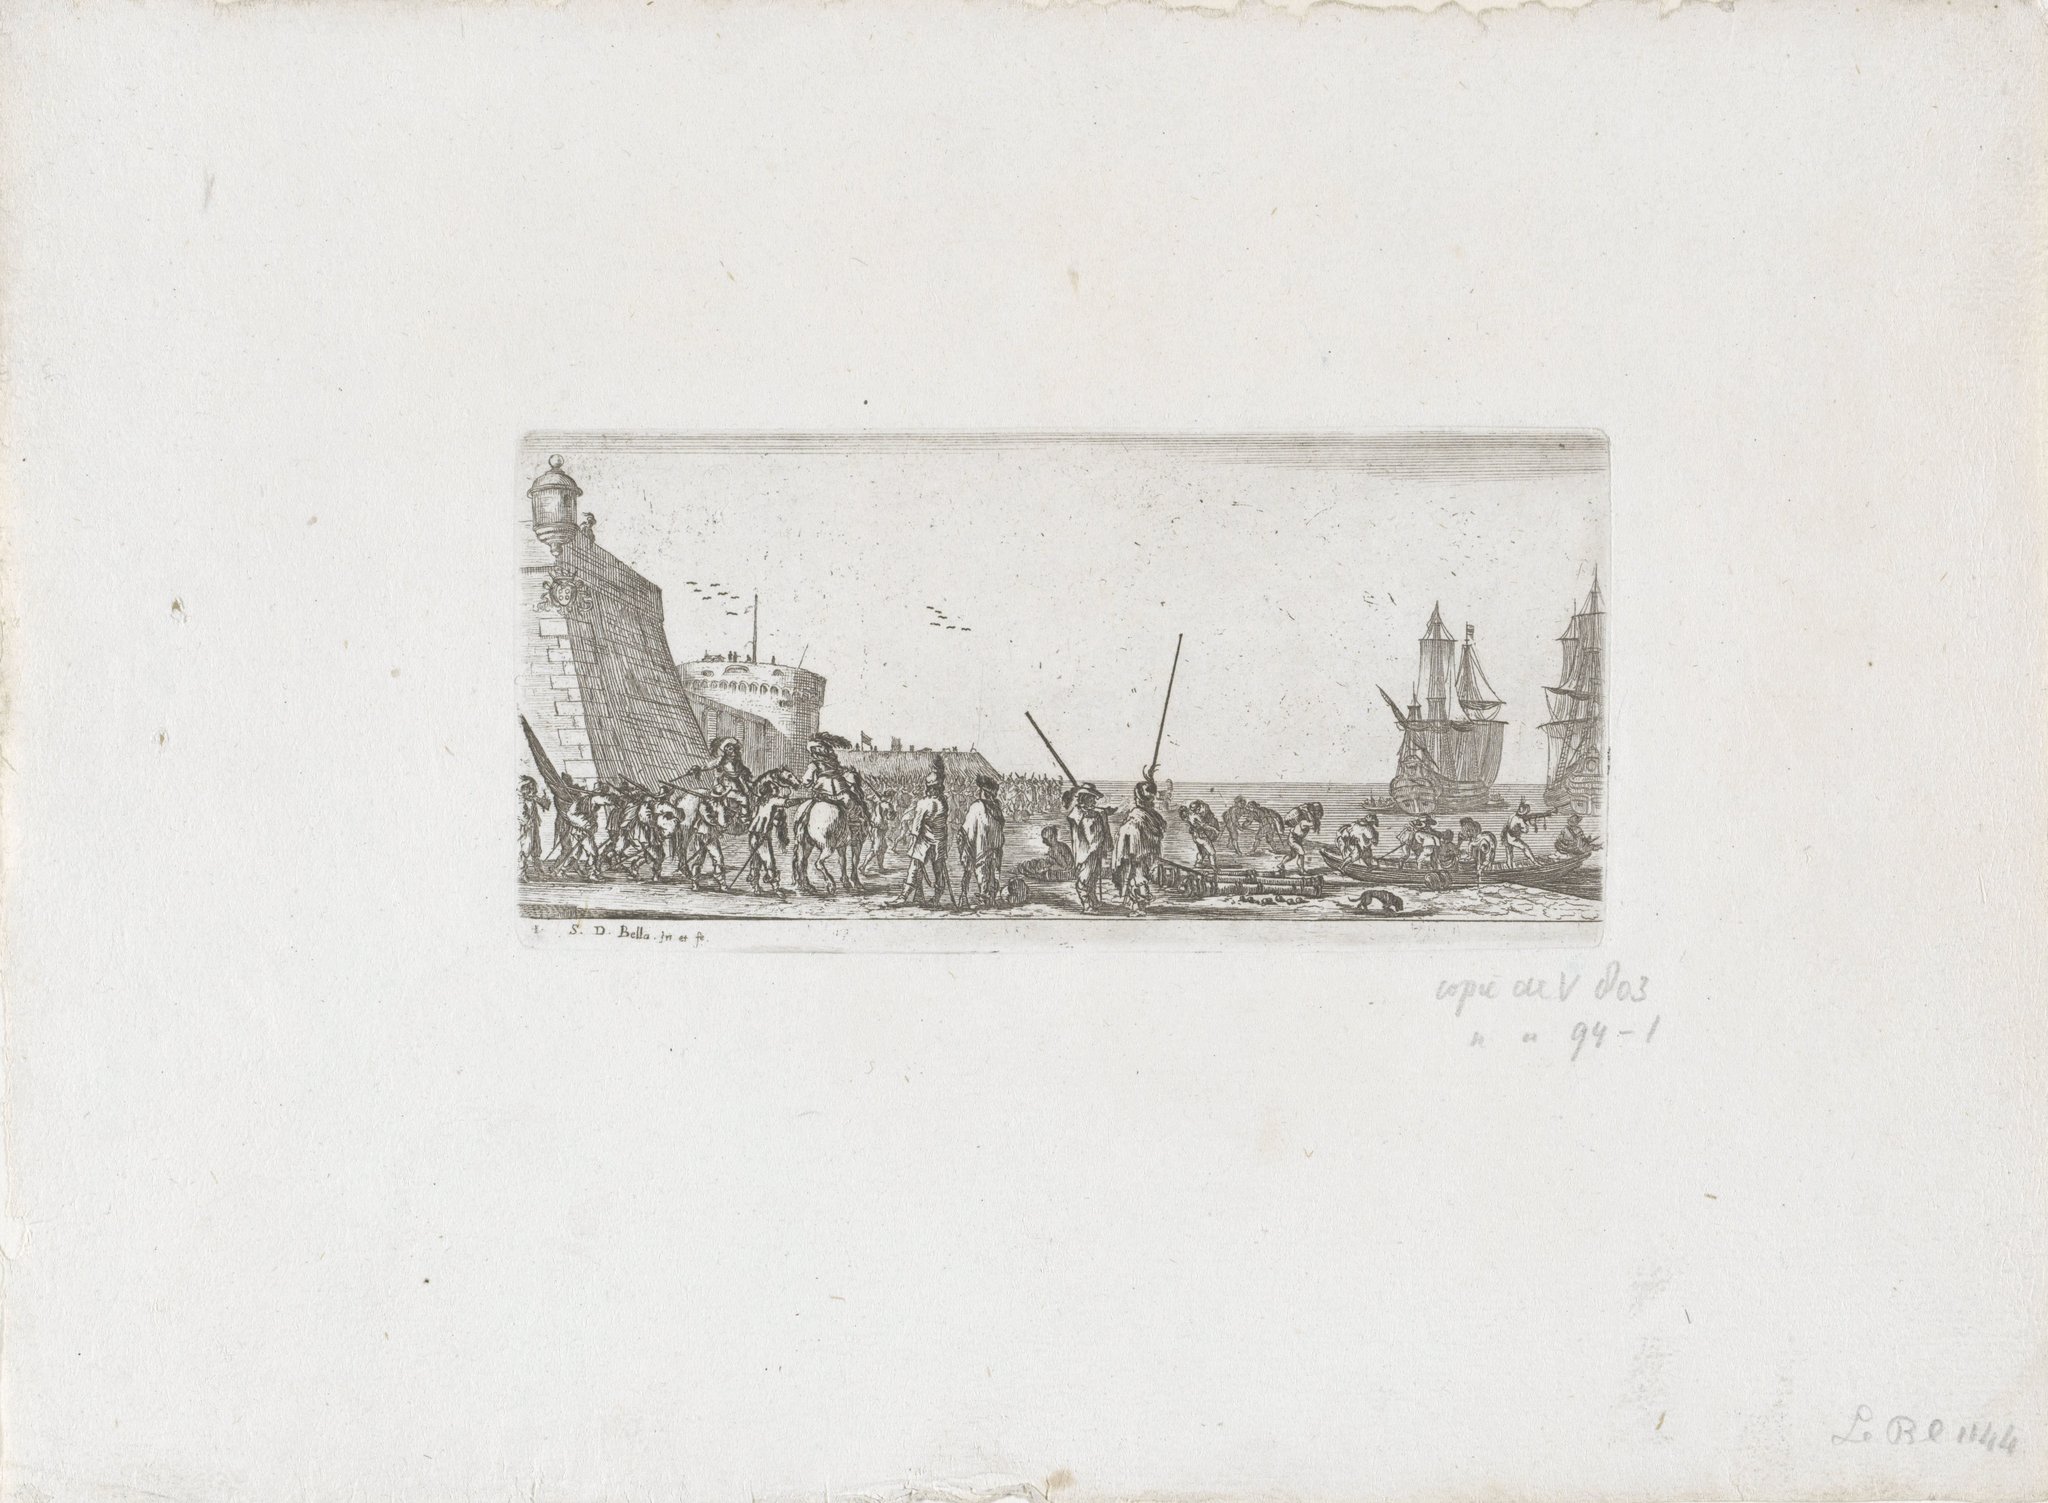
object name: print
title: Divers embarquements (kopieën)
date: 1620-1664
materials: paper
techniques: etching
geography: italy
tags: harbour, riding a horse, ass, or mule; rider, horseman, dock labourer, ships (in general), ship bound for the harbour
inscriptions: collector's mark: Lugt 2228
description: Prent uit een reeks van negen prenten. Zeven prenten zijn spiegelbeeldige en genummerde kopieën naar prenten van Stefano della Bella. Twee prenten zijn nieuwe inventies. Mogelijk is deze gekopieerde reeks ook door Della Bella zelf vervaardigd.